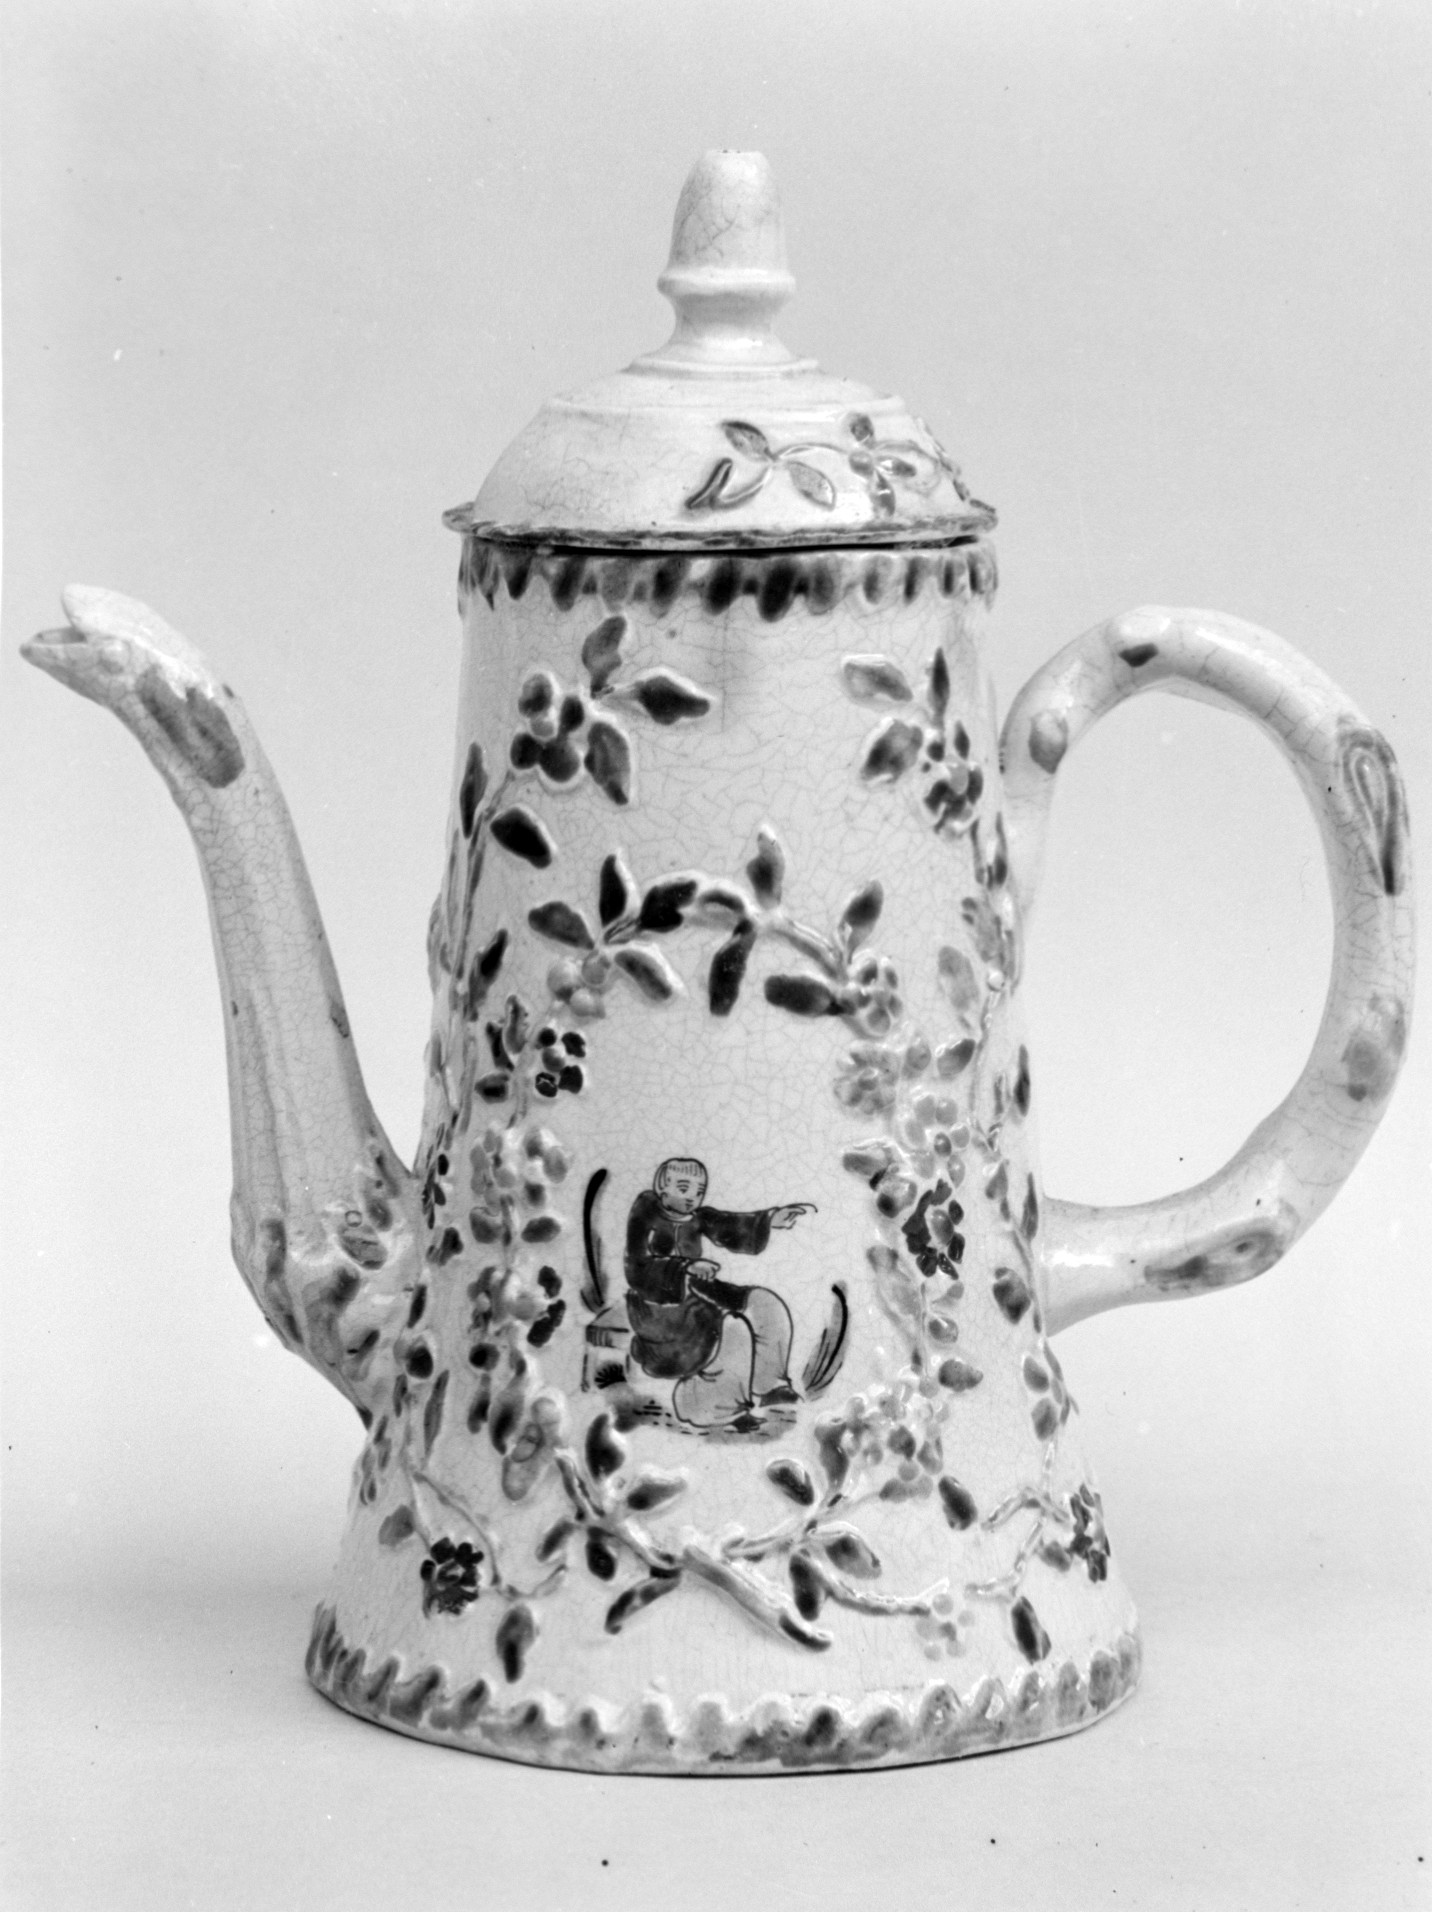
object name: coffeepot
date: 1750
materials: stoneware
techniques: salt glaze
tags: men